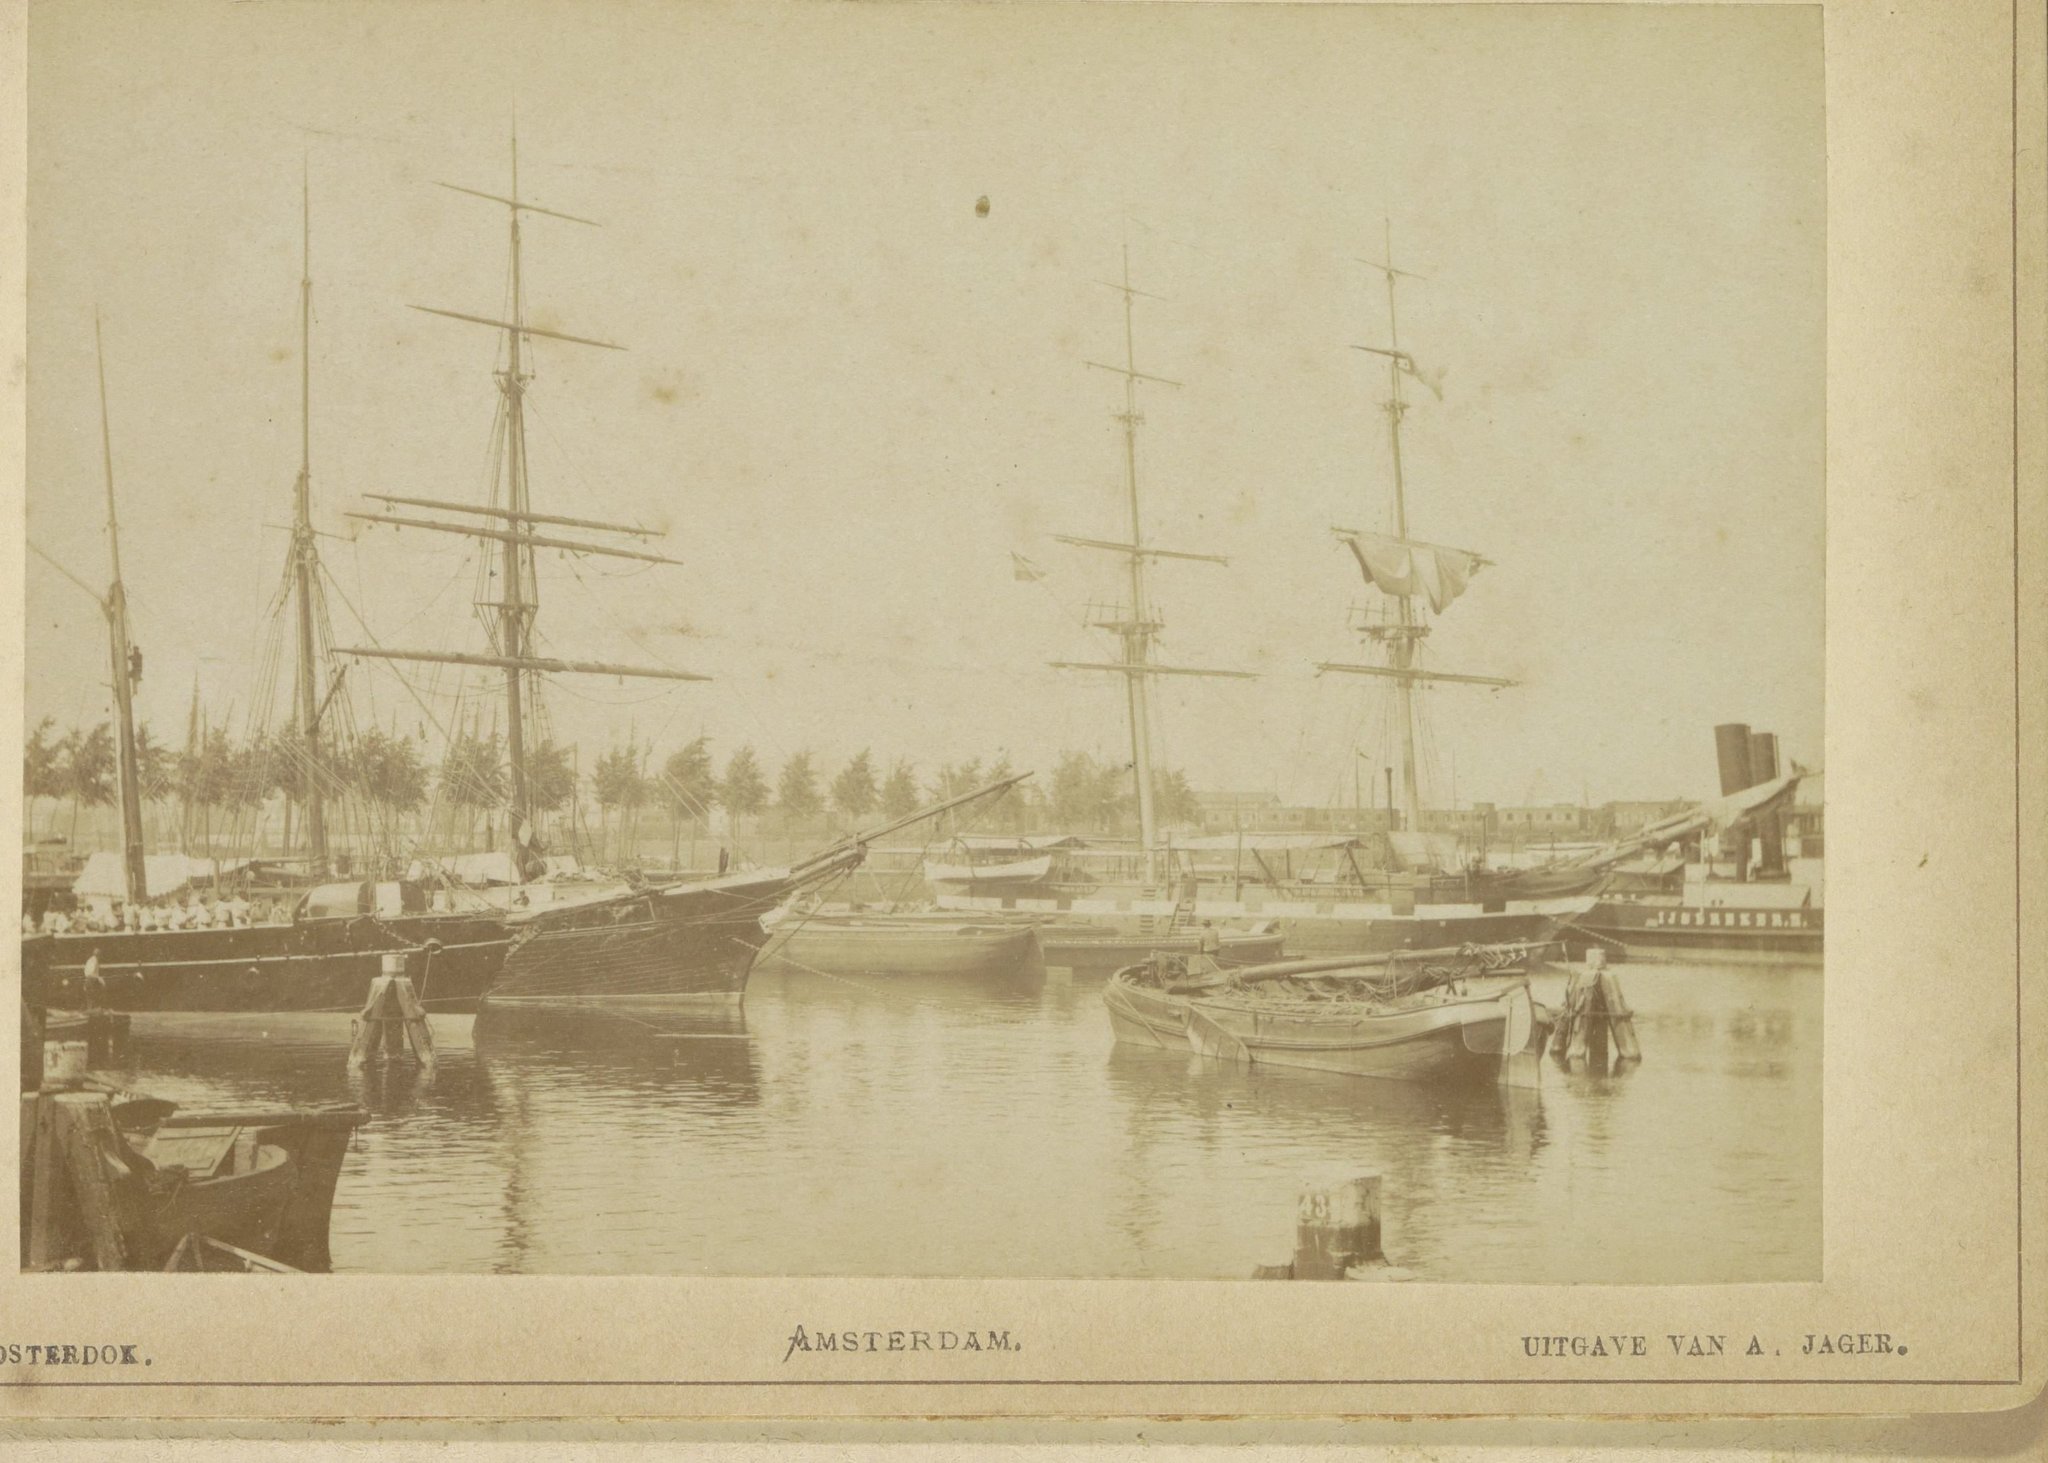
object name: photograph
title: Het Oosterdok. Amsterdam.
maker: andries jager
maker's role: publisher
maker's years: 1825-1905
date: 1860-1907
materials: cardboard, photographic support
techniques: albumen print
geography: amsterdam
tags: sailing-ship, sailing-boat, harbour (+ view ~ vehicle, ship, etc.)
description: Onderdeel van Leporelloalbum met 24 foto's van Amsterdam.